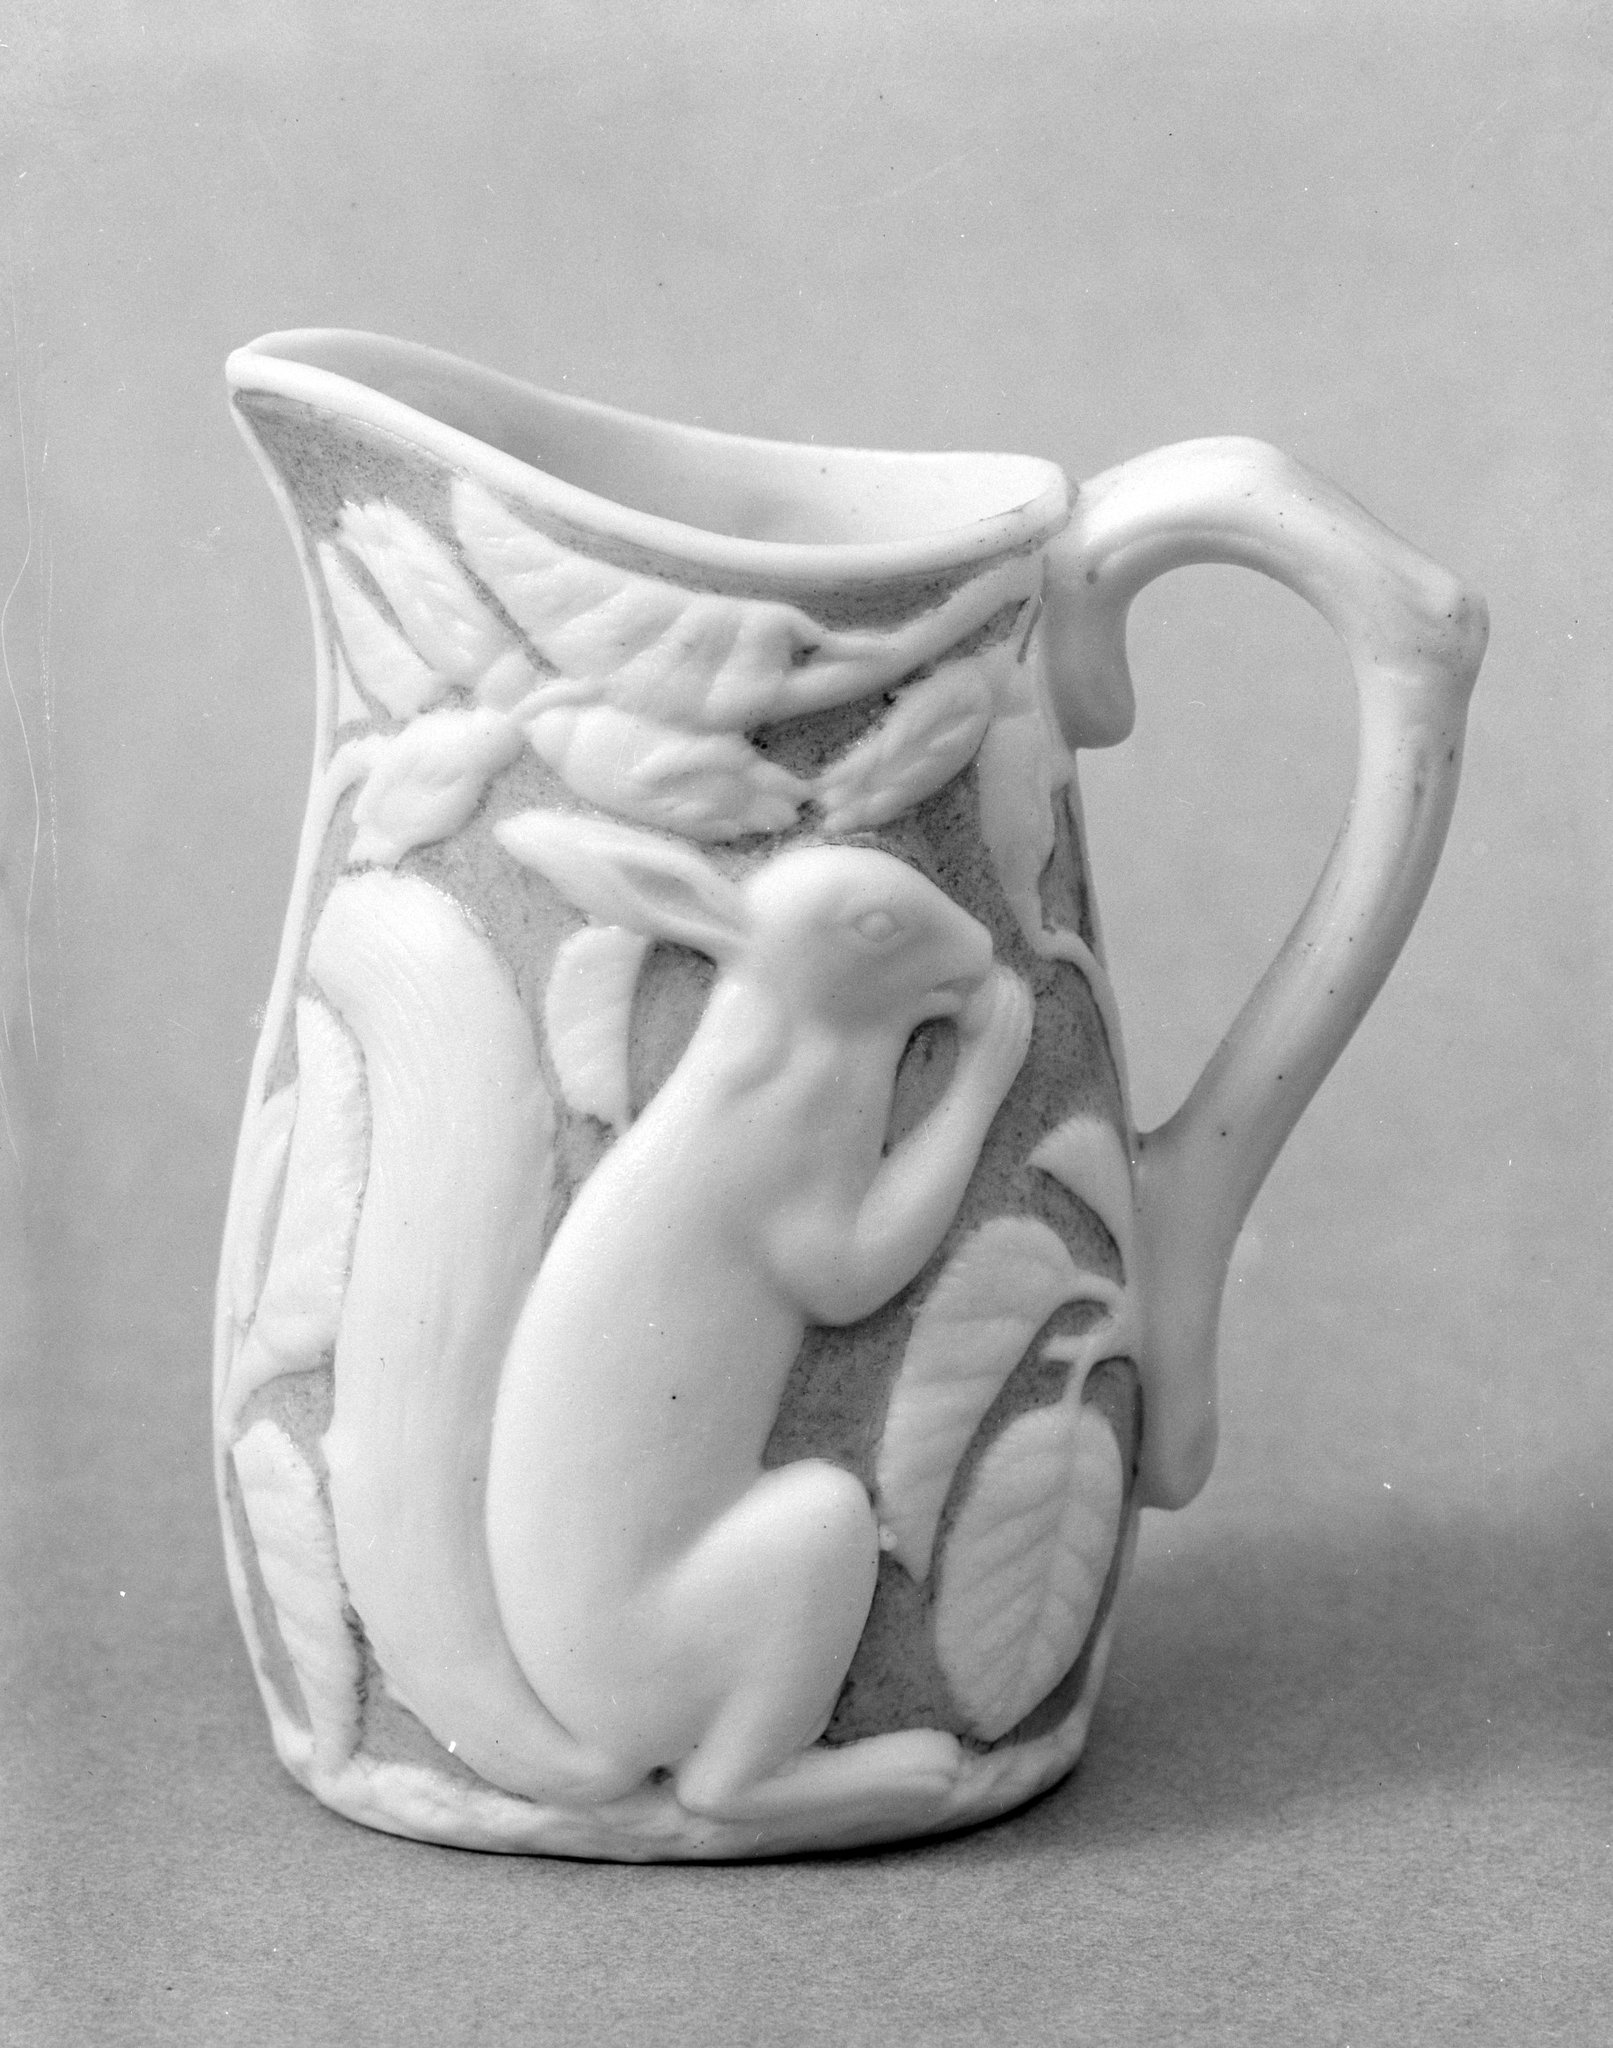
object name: pitcher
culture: american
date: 1830-1870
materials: porcelain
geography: united states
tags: squirrels